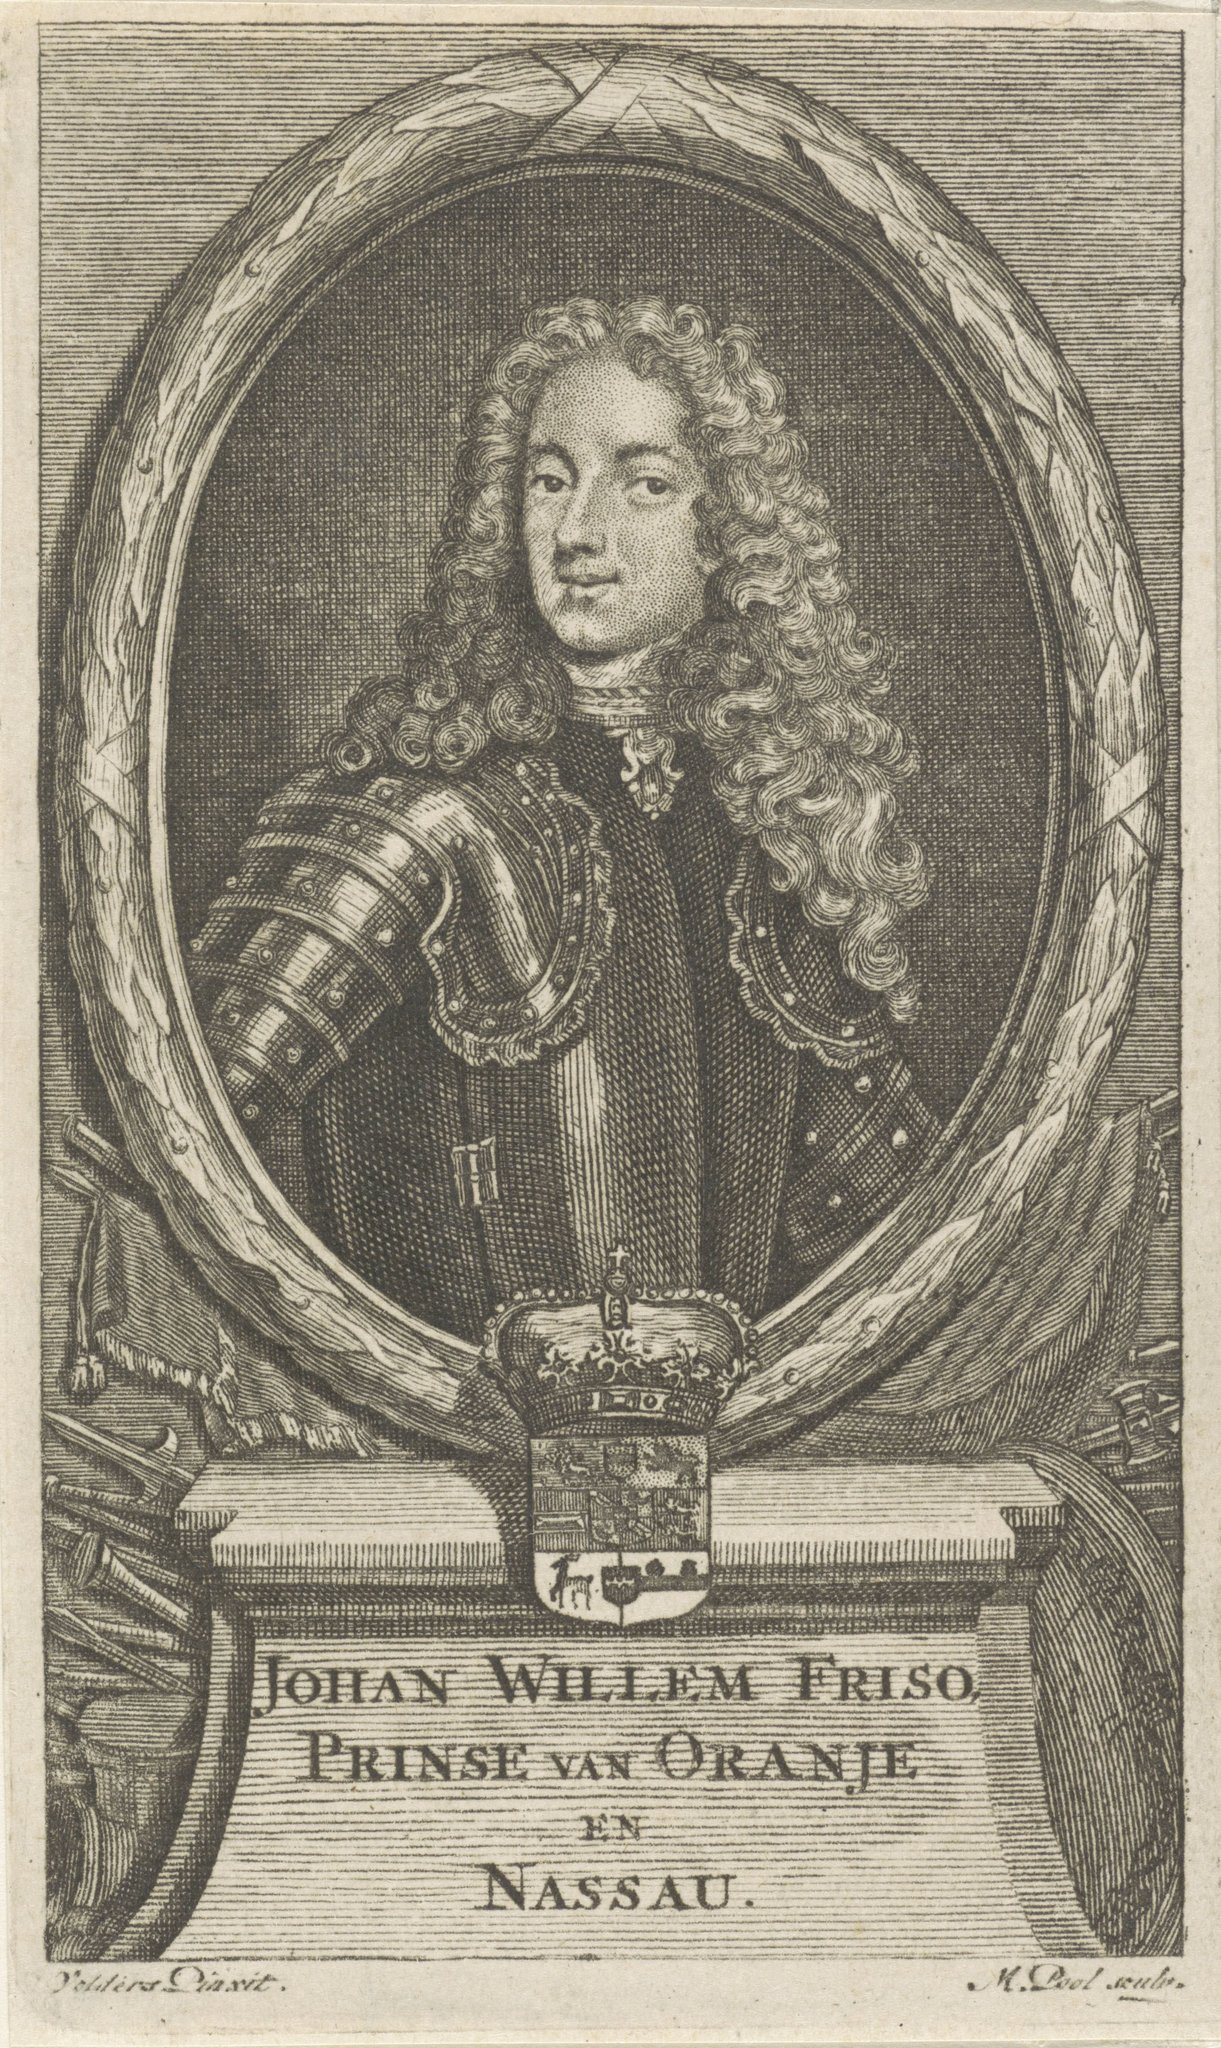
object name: print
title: Portret van Johan Willem Friso, prins van Oranje-Nassau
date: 1705-1740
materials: paper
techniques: engraving, etching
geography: amsterdam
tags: johan willem friso (prins van oranje-nassau)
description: Portret van Johan Willem Friso in een ovaal van lauwerbladen. Daar omheen een aantal allegorische objecten. Midden onder zijn wapen met een kroon. Op een voetstuk zijn naam en titel.